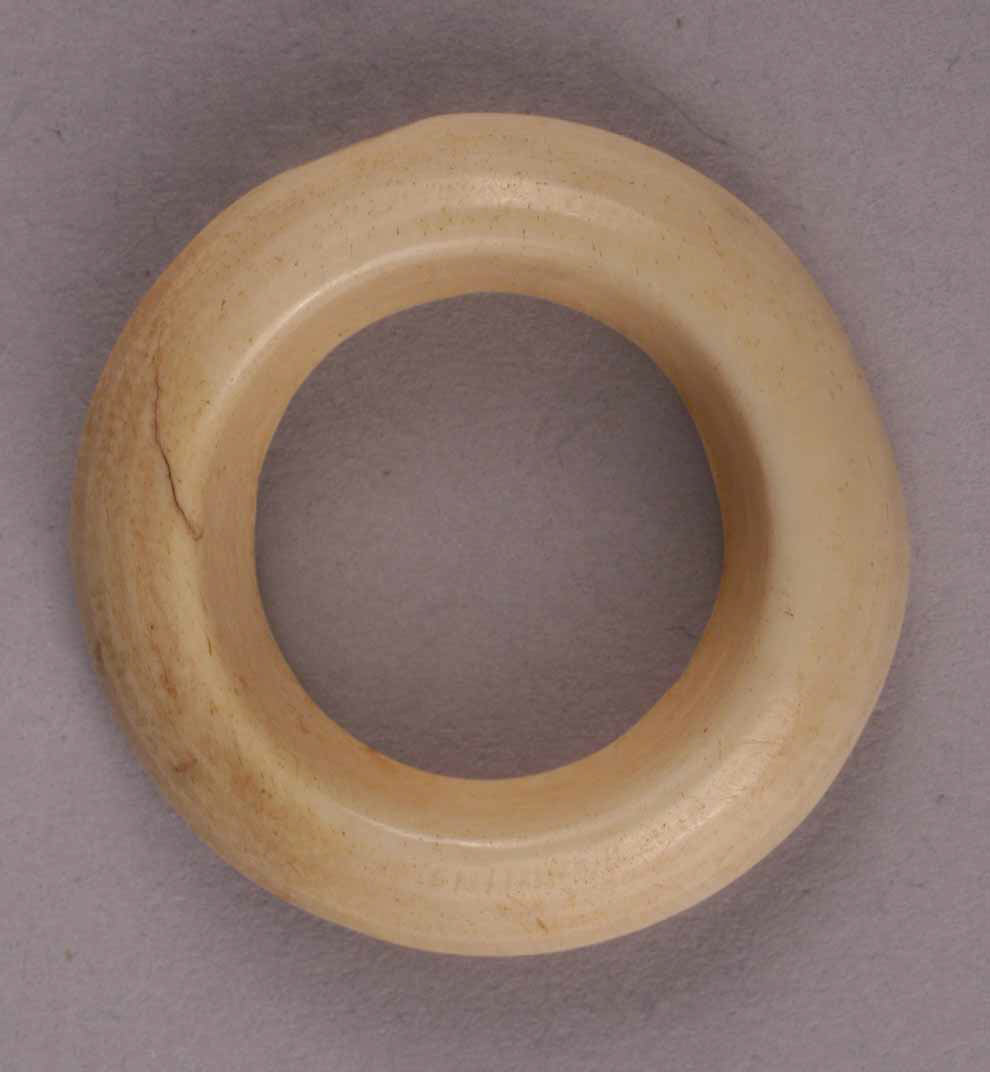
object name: ring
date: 801-1000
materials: bone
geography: iran